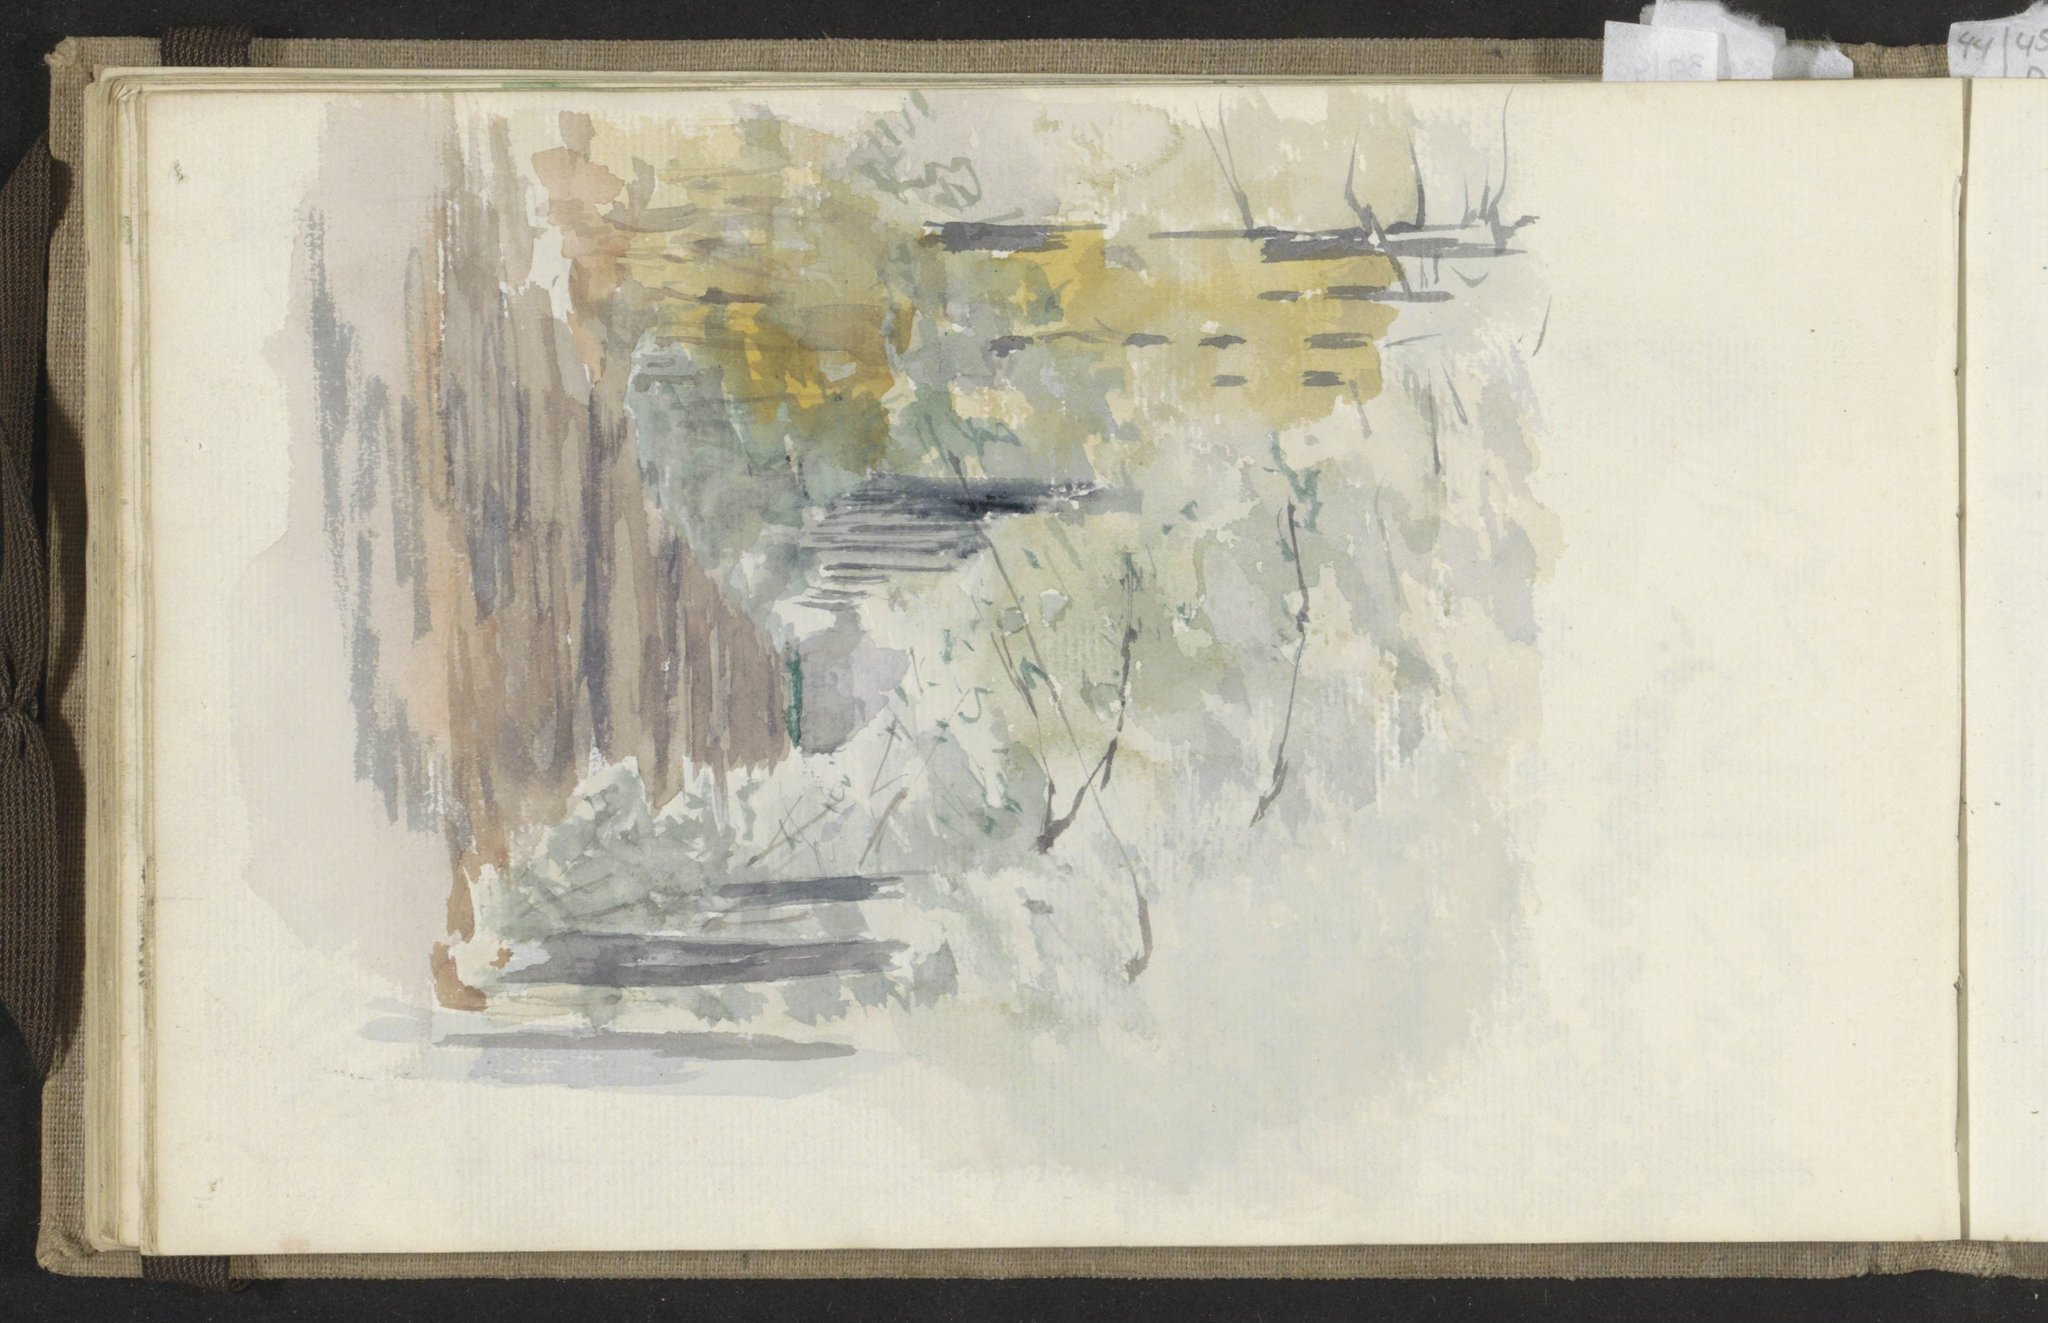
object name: sketchbook leaf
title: Bospad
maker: jonkheer johannes ludovicus paulus bosch van drakestein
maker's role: draughtsman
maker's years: 1865-1929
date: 1896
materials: paper, watercolor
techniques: brush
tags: forest path or lane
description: Blad 41 verso uit een schetsboek met 58 bladen.